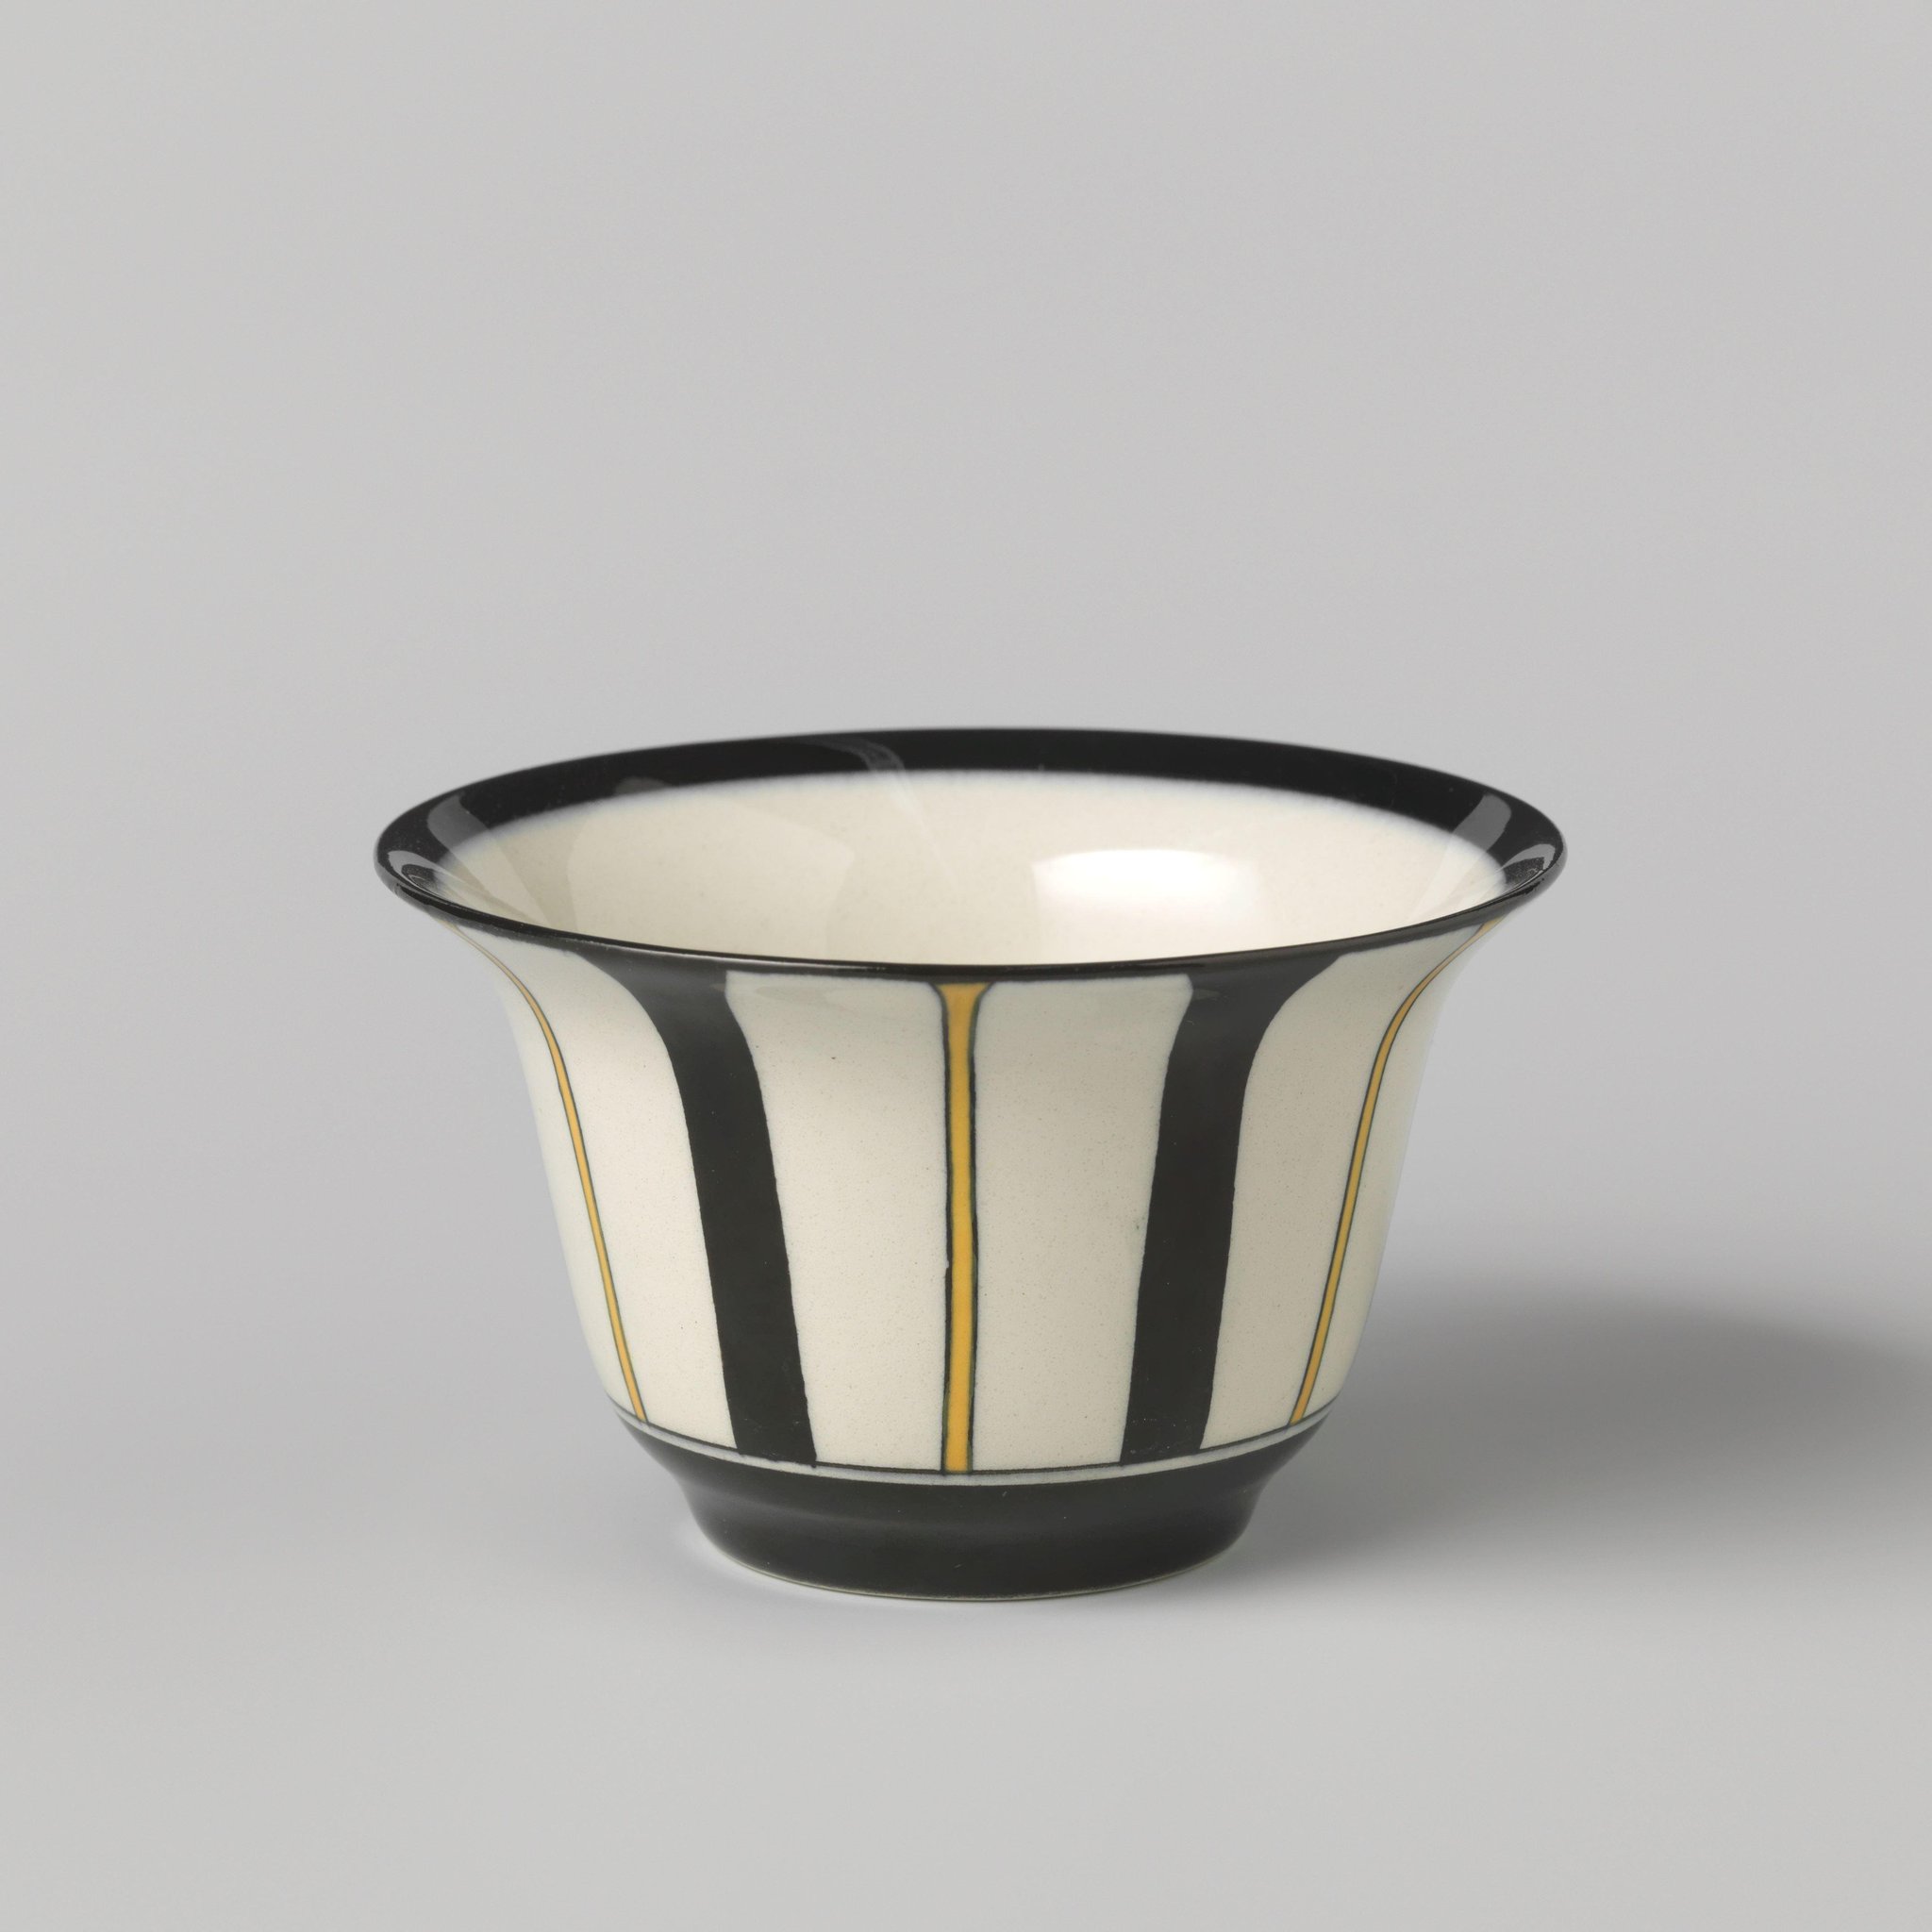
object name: cup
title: Kop met lijnendecor in geel en zwart op crème fond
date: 1925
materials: earthenware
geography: arnhem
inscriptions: mark: ‘cirkelvormig stempel in zwart: Colenbrander "Ram" Arnhem-Holland rondom een ramskop, 110.’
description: kop van aardewerk met lijnendecor in geel en zwart op crème fond. De mond- en voetrand zijn zwart. Gemerkt met cirkelvormig stempel in zwart: Colenbrander "Ram" Arnhem-Holland rondom een ramskop, 110.